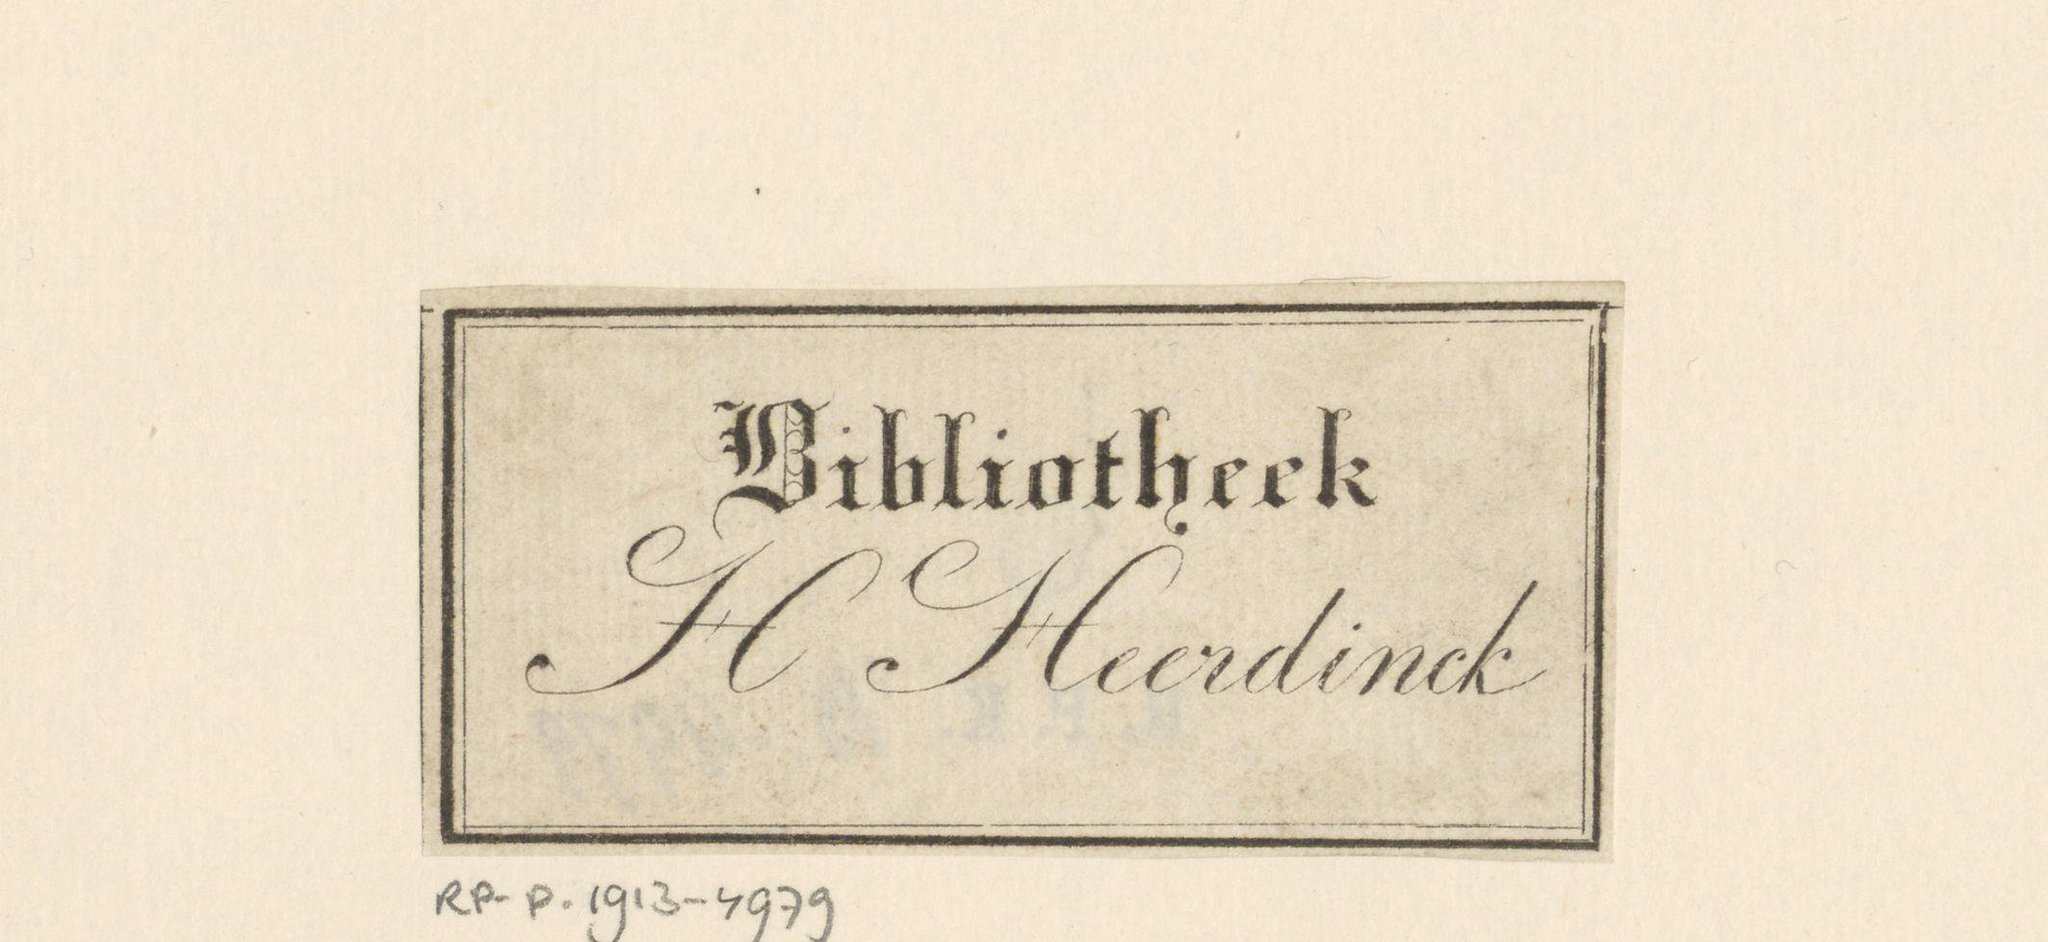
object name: bookplate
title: Ex libris van H. Heerdinck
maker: Anonymous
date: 1800-1899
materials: paper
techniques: etching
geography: netherlands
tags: h. heerdinck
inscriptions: collector's mark: Lugt 2760, collector's mark: Lugt 2233